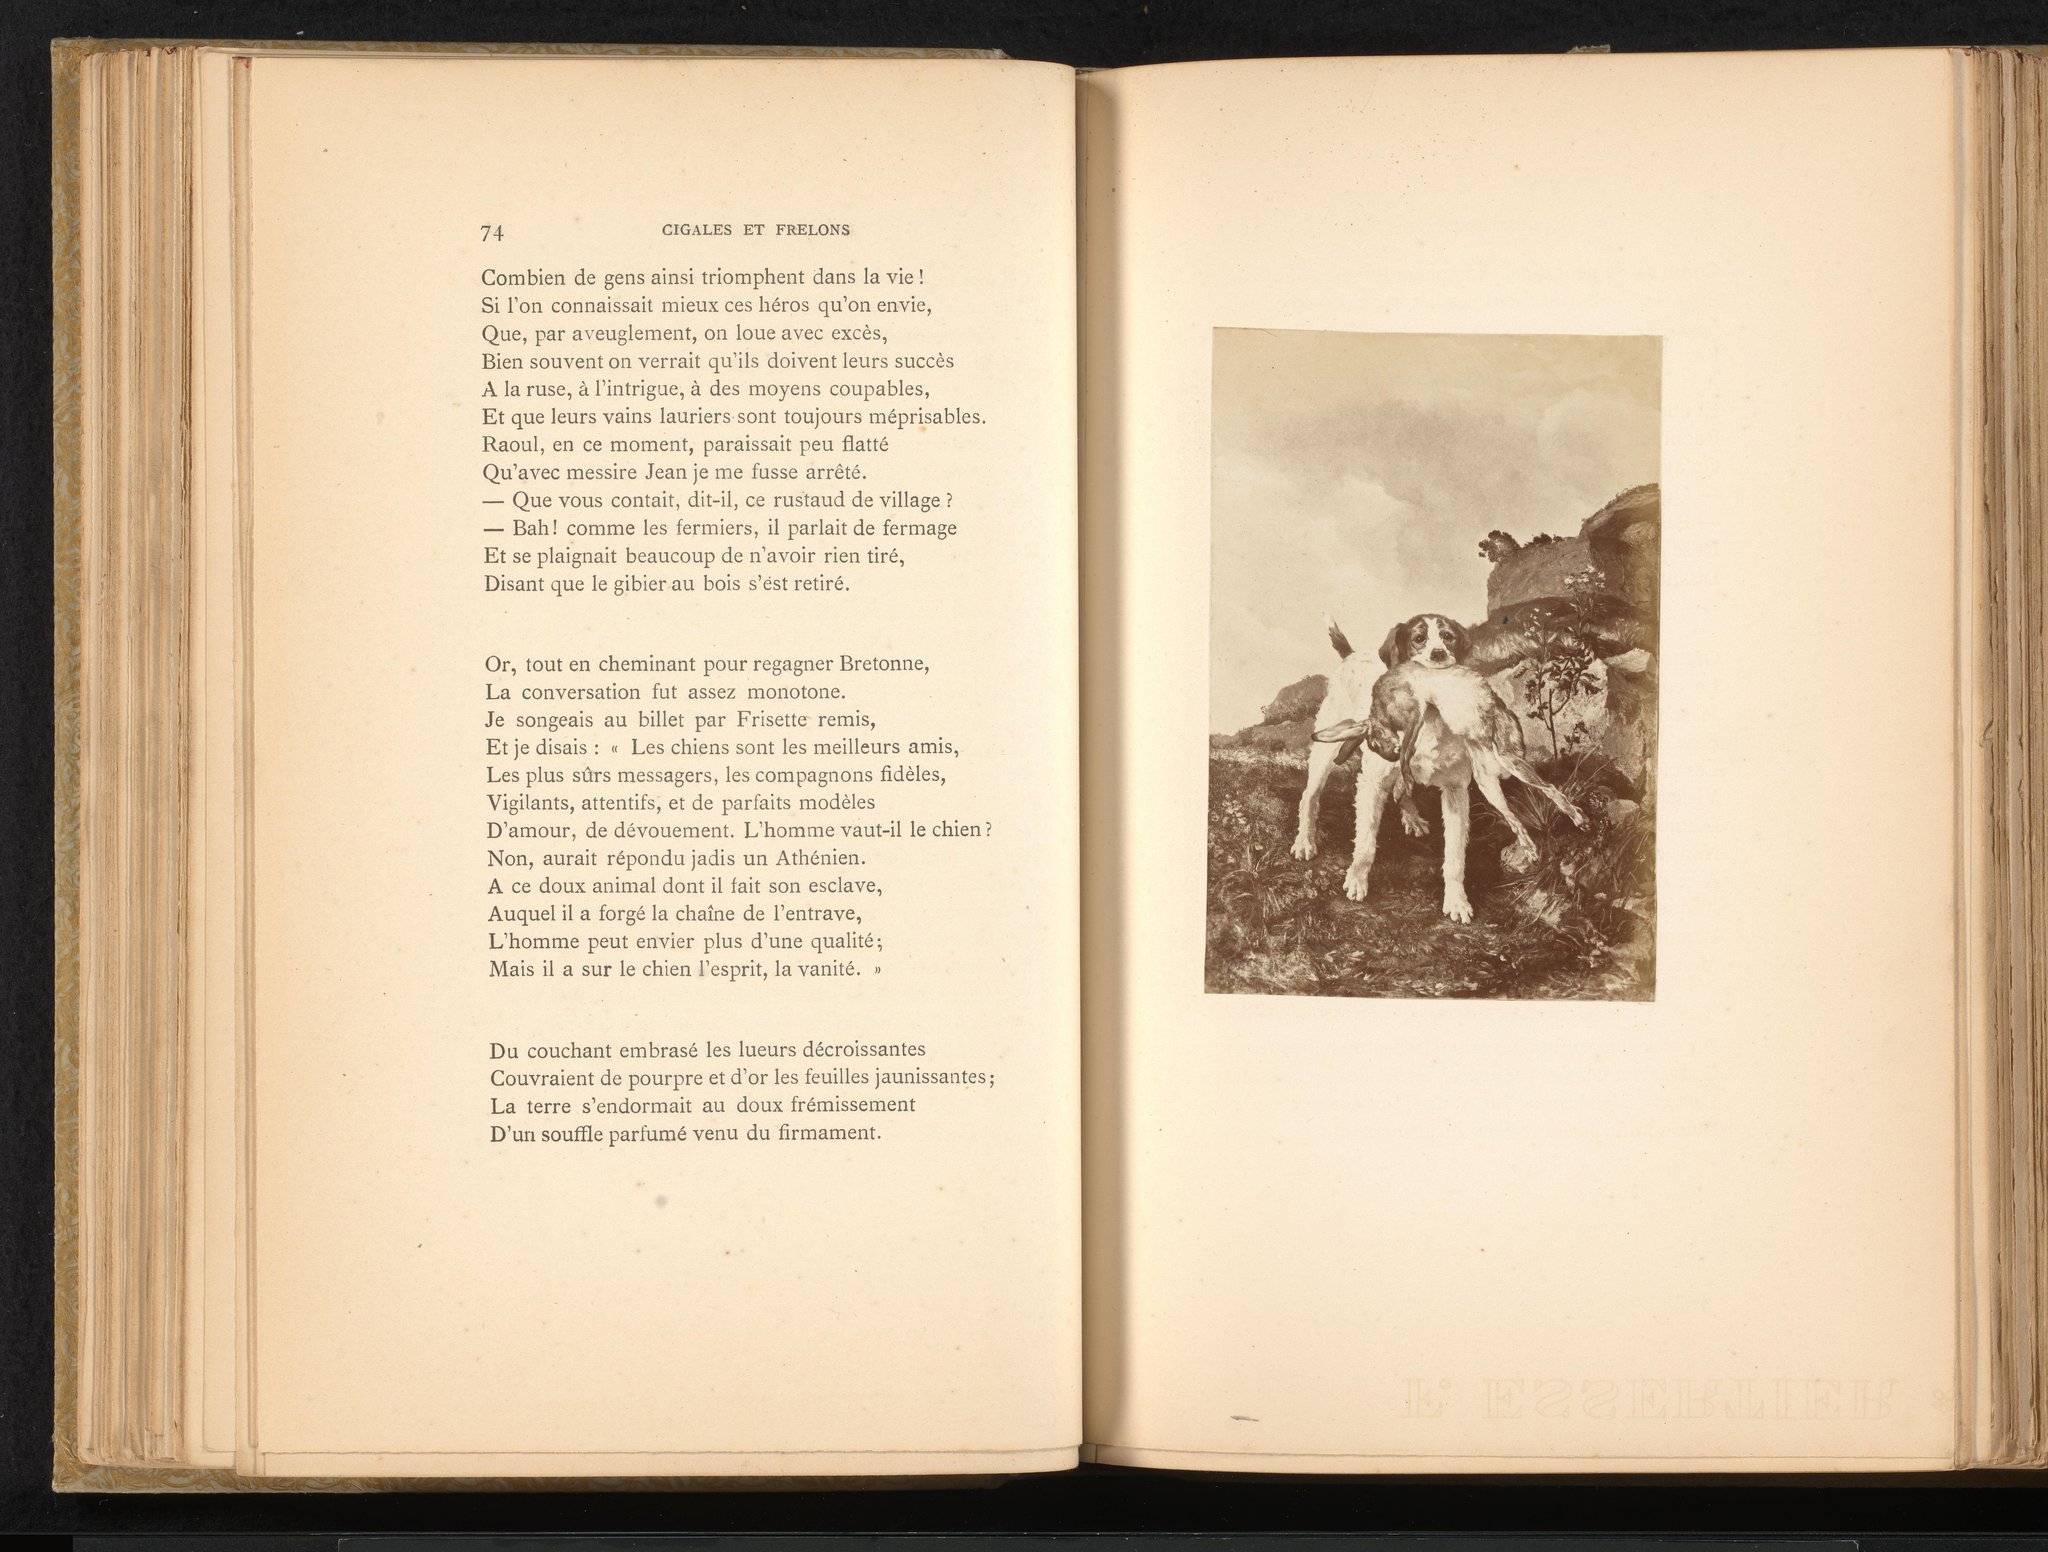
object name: page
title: Fotoreproductie van een schilderij van een hond met een haas in de bek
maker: Anonymous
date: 1874-1884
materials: paper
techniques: albumen print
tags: hare-hunting, rabbit-hunting, picture, painting, dog